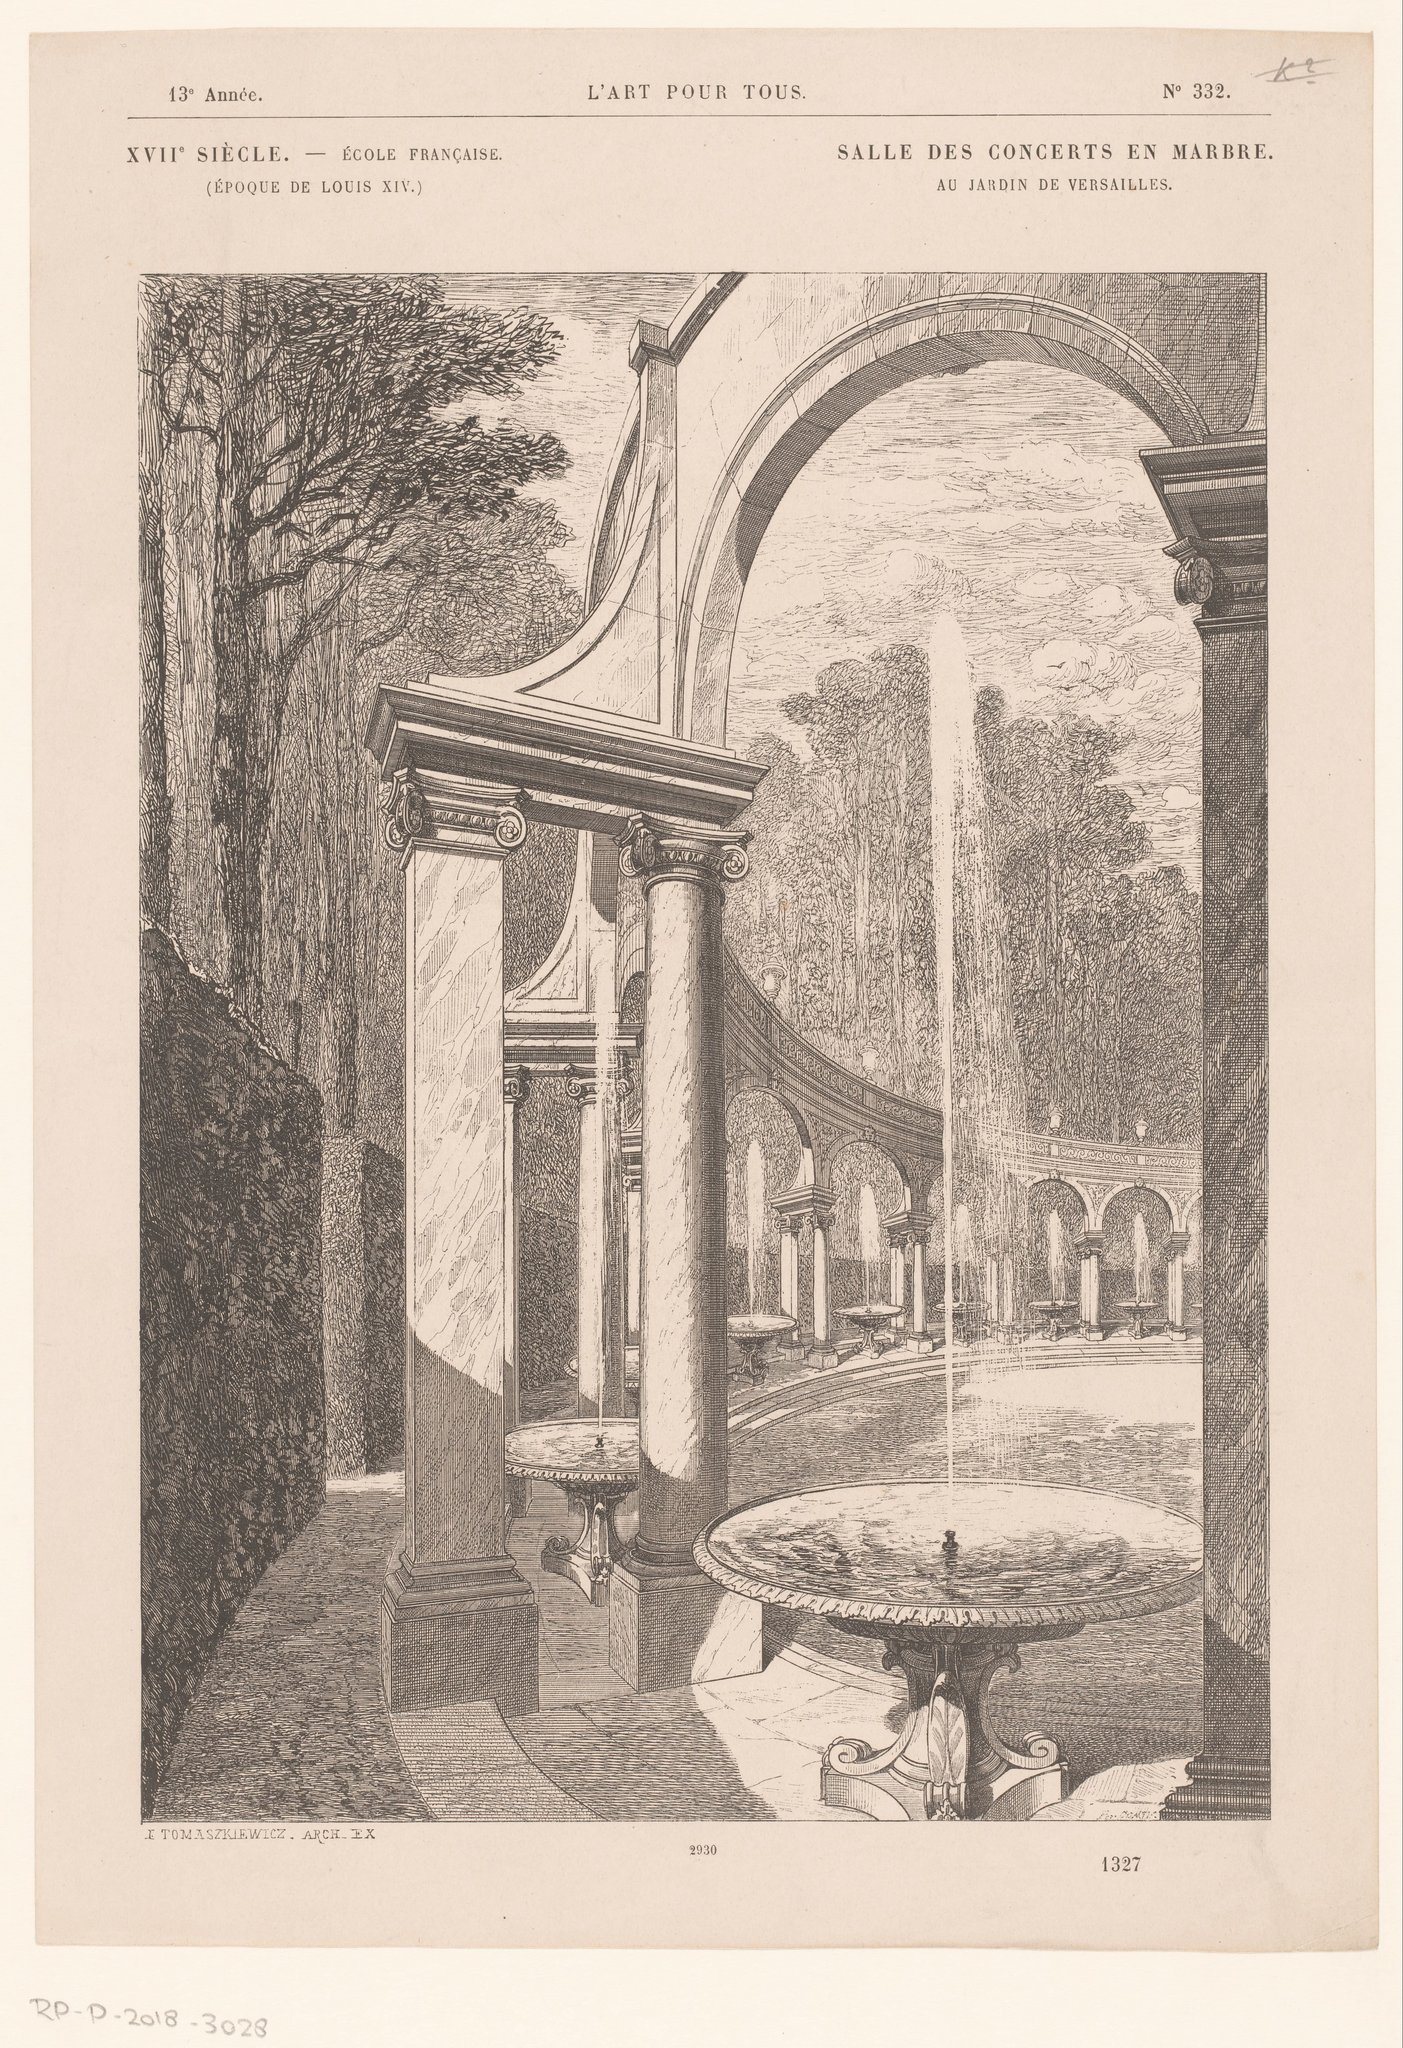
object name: print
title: Salle des concerts en marbre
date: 1874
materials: paper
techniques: lithograph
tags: statues, sculptures in garden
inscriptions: collector's mark: Lugt 3937, collector's mark: Lugt 2228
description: Prent uit: Sauvageot (ed.). L'Art Pour Tous, encyclopédie de l'art industriel et decoratif (1874). Nr. 332.